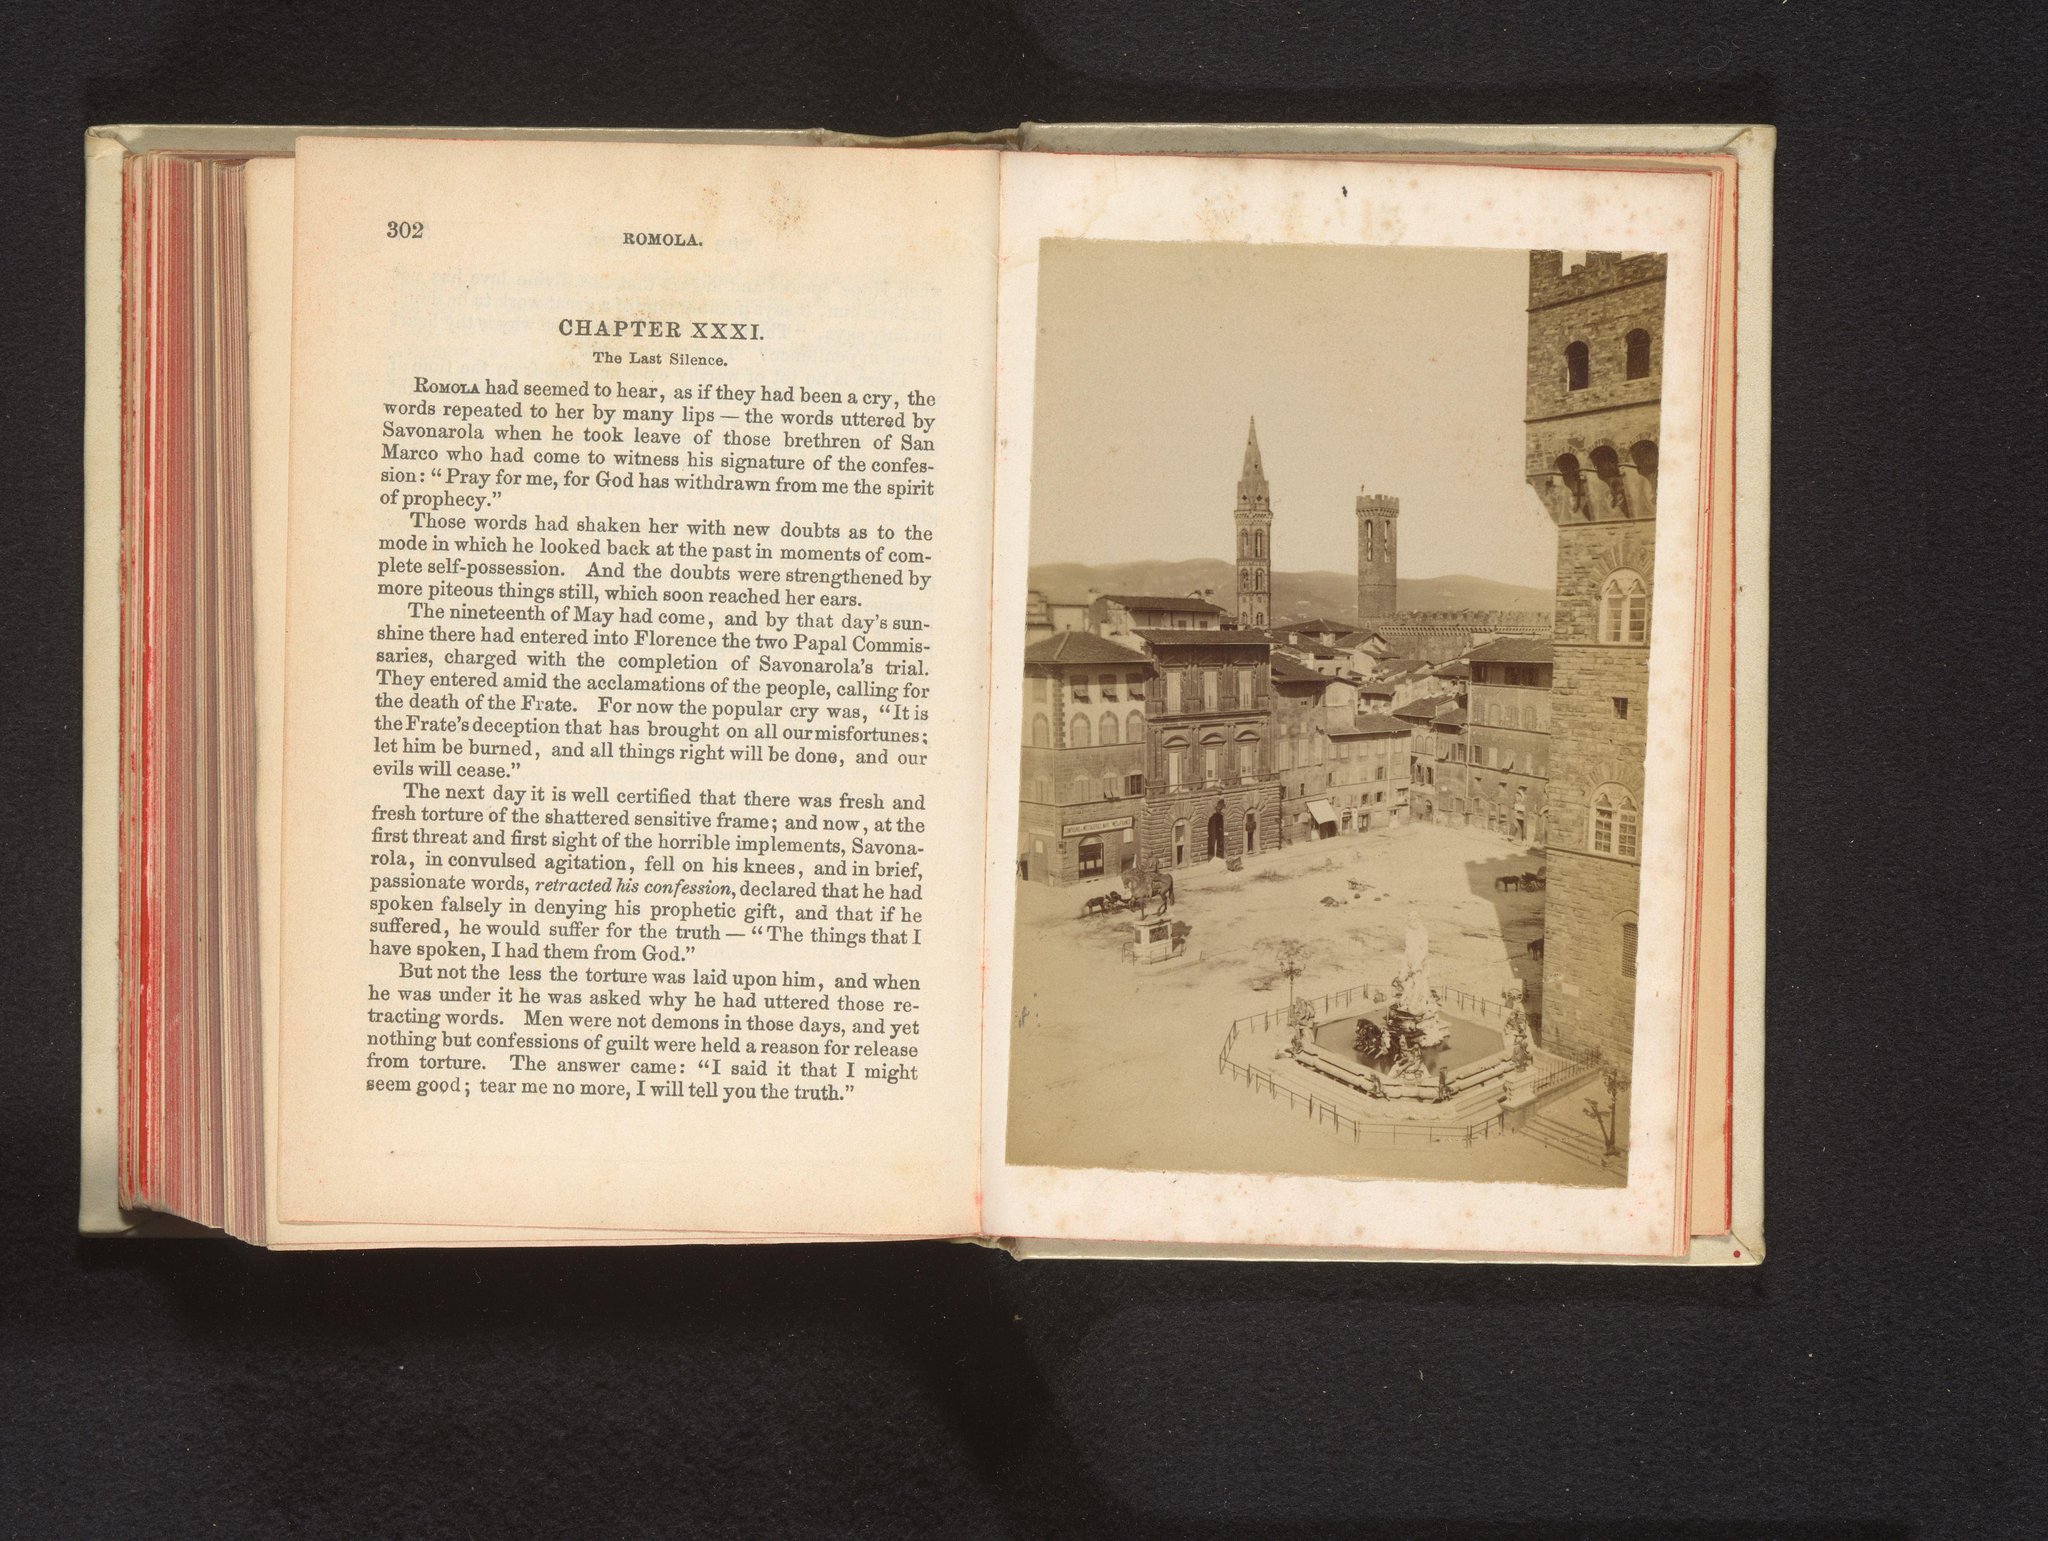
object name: photograph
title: Gezicht op het Piazza della Signoria te Florence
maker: Anonymous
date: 1858-1863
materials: photographic support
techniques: albumen print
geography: piazza della signoria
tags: façade (of house or building), village square, place